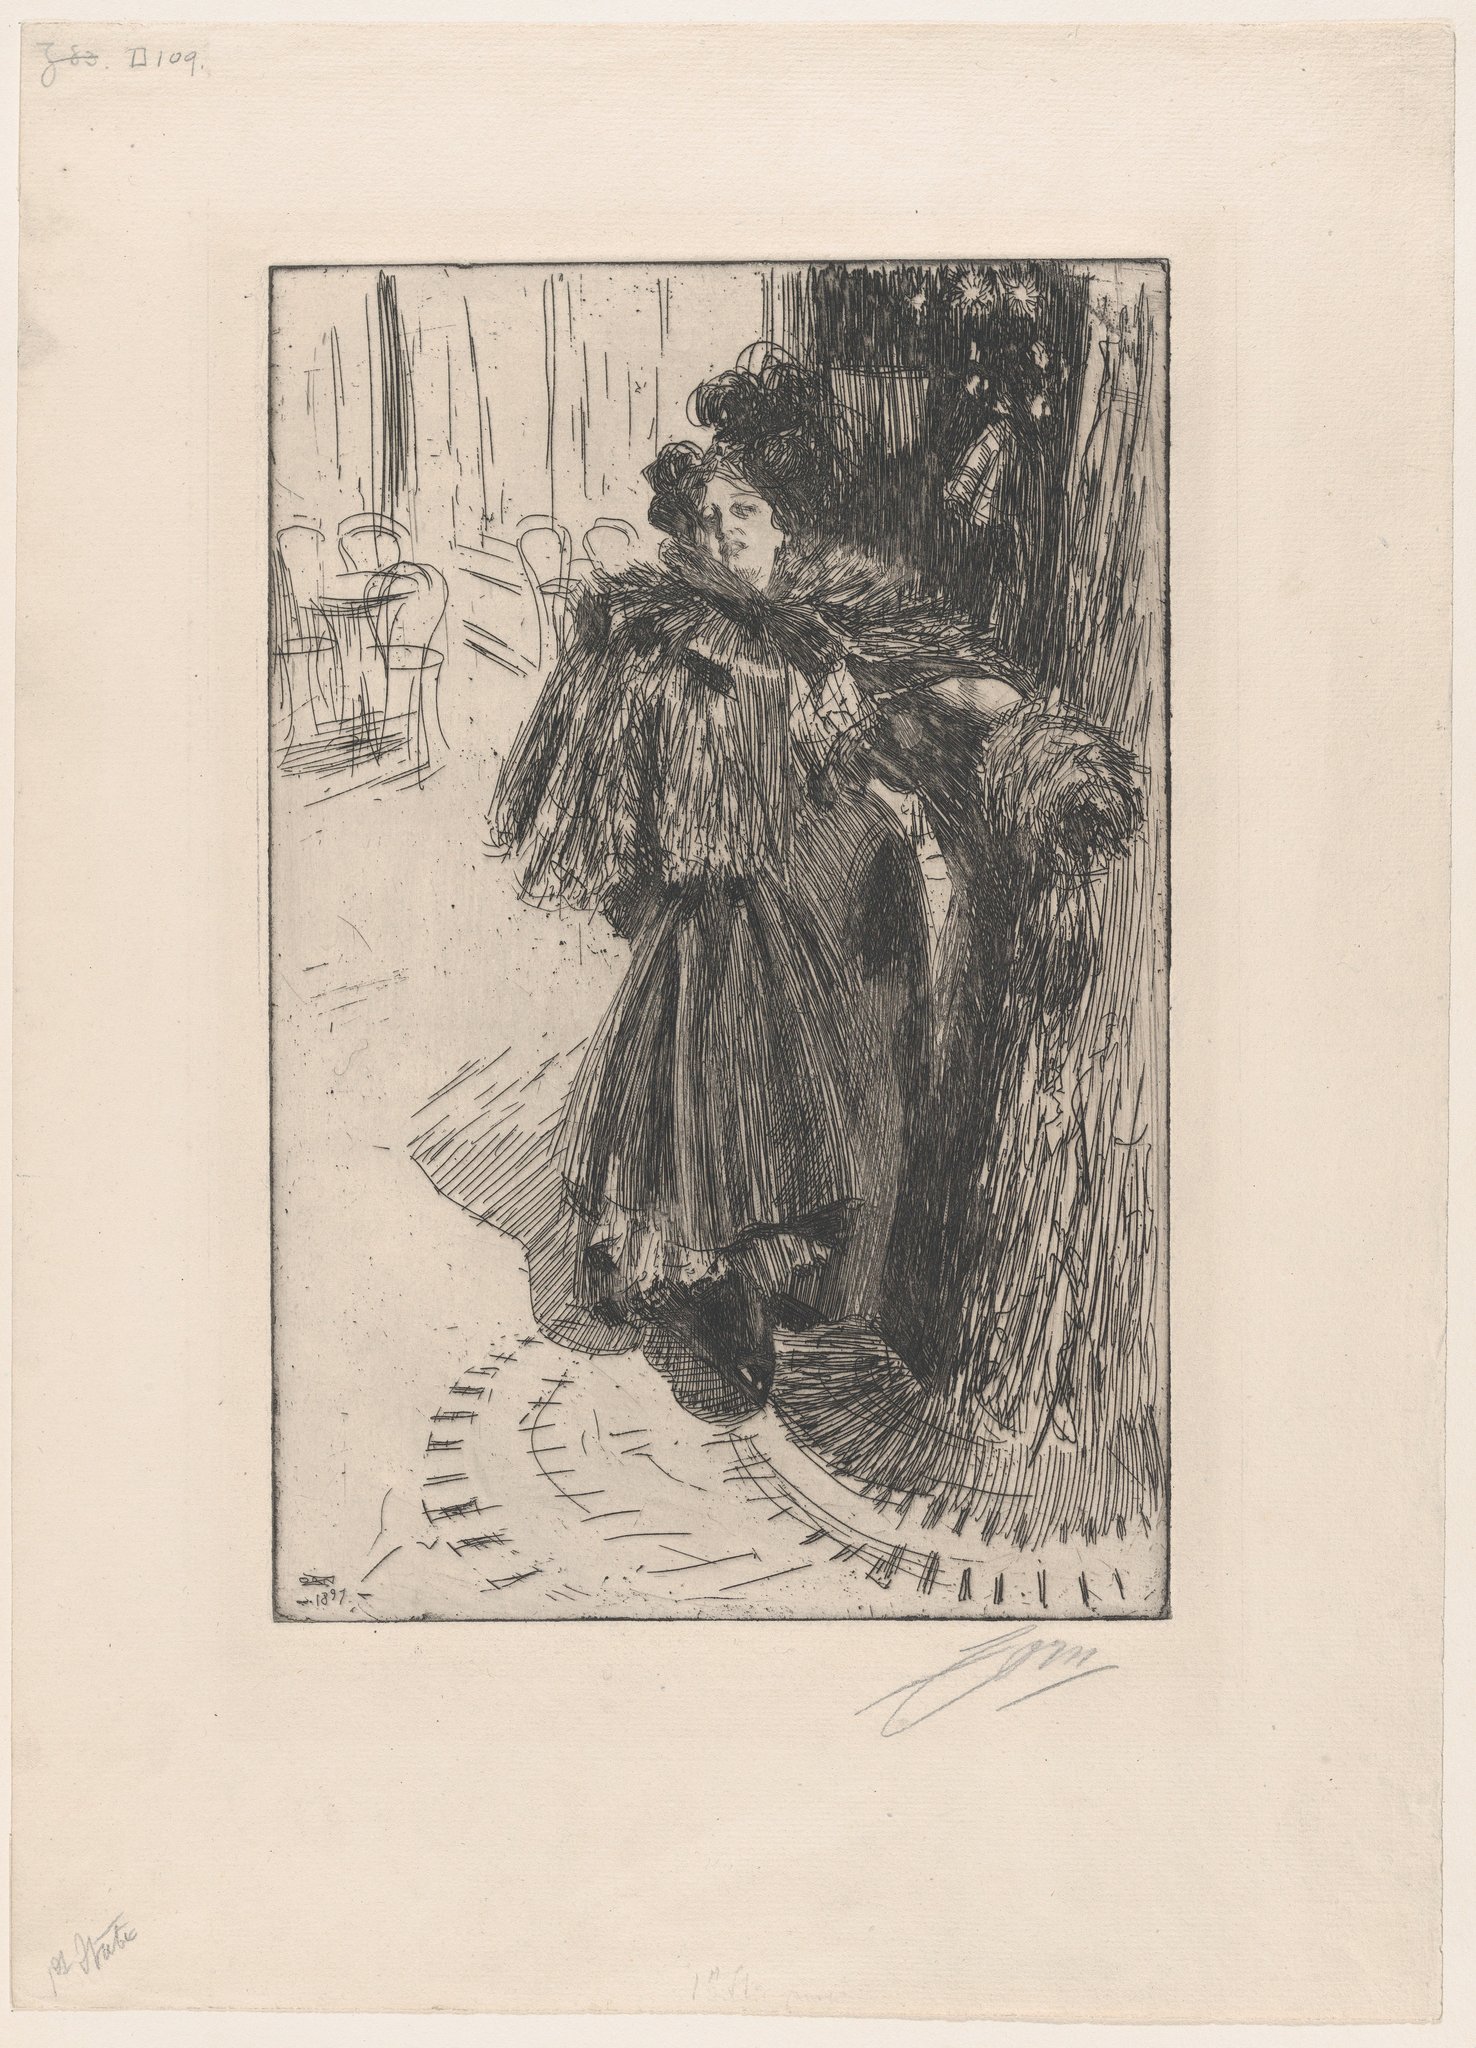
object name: print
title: At Night III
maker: anders zorn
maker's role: artist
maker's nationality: swedish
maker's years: 1860-1920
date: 1897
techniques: etching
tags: women,night